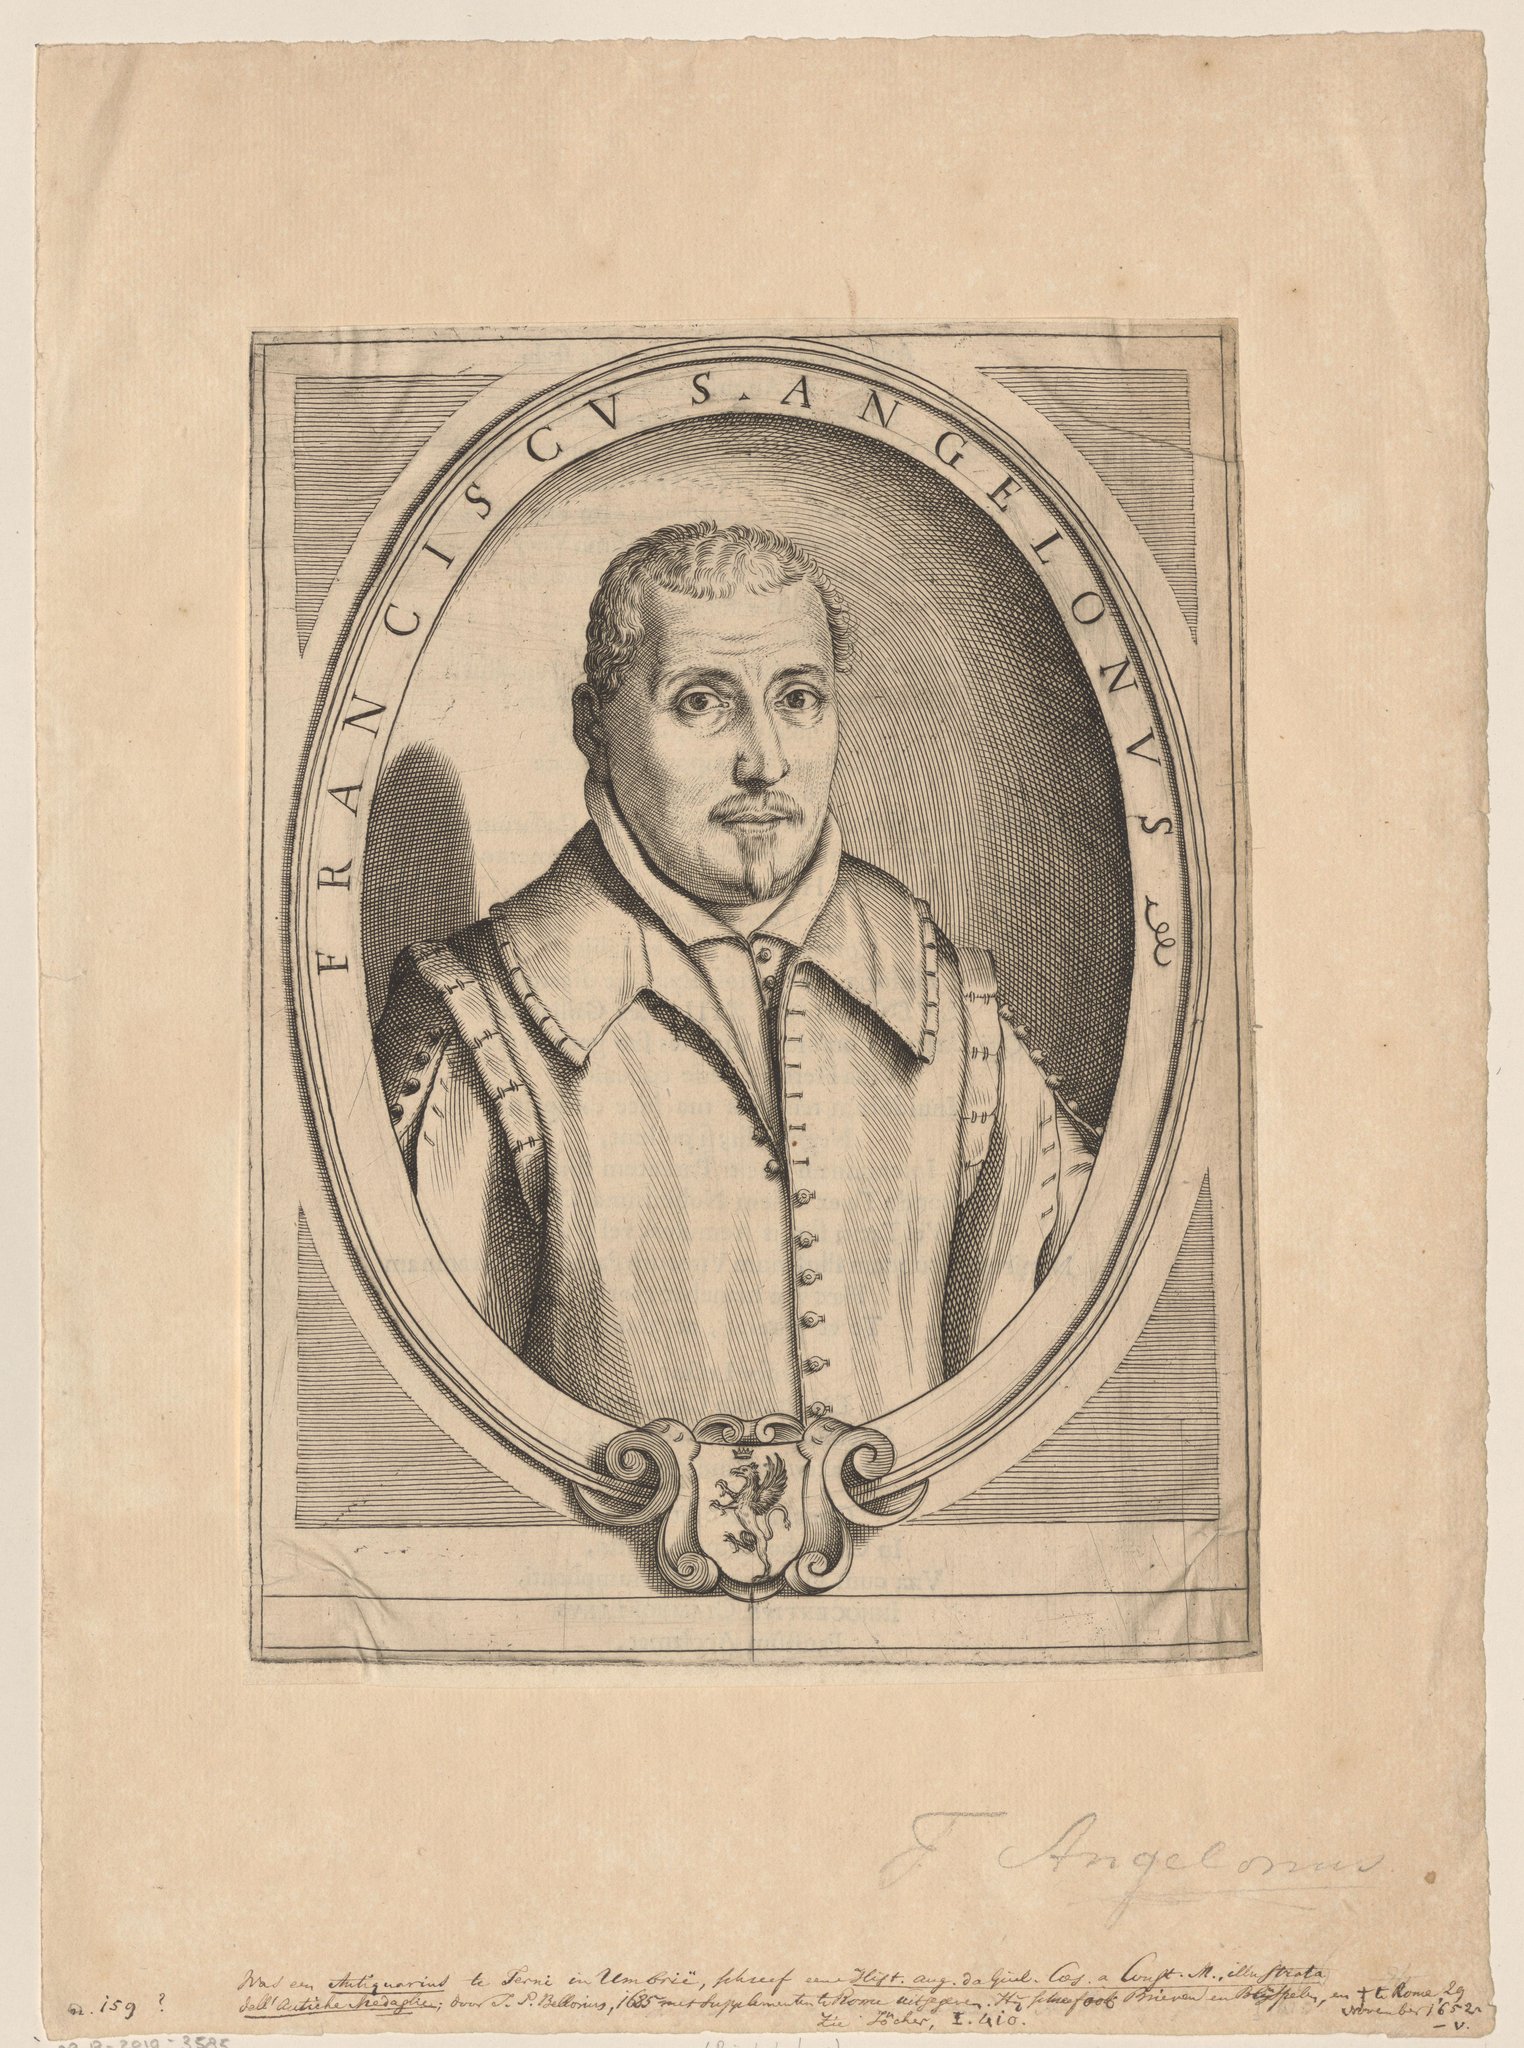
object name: print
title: Portret van Francesco Angeloni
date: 1641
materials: paper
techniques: engraving, etching, letterpress printing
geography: rome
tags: historical persons, portrait of a writer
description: Prent uit: Angeloni, Francesco. La historia augusta da Giulio Cesare infino à Costanino il Magno. Rome: Andrea Fei, 1641.